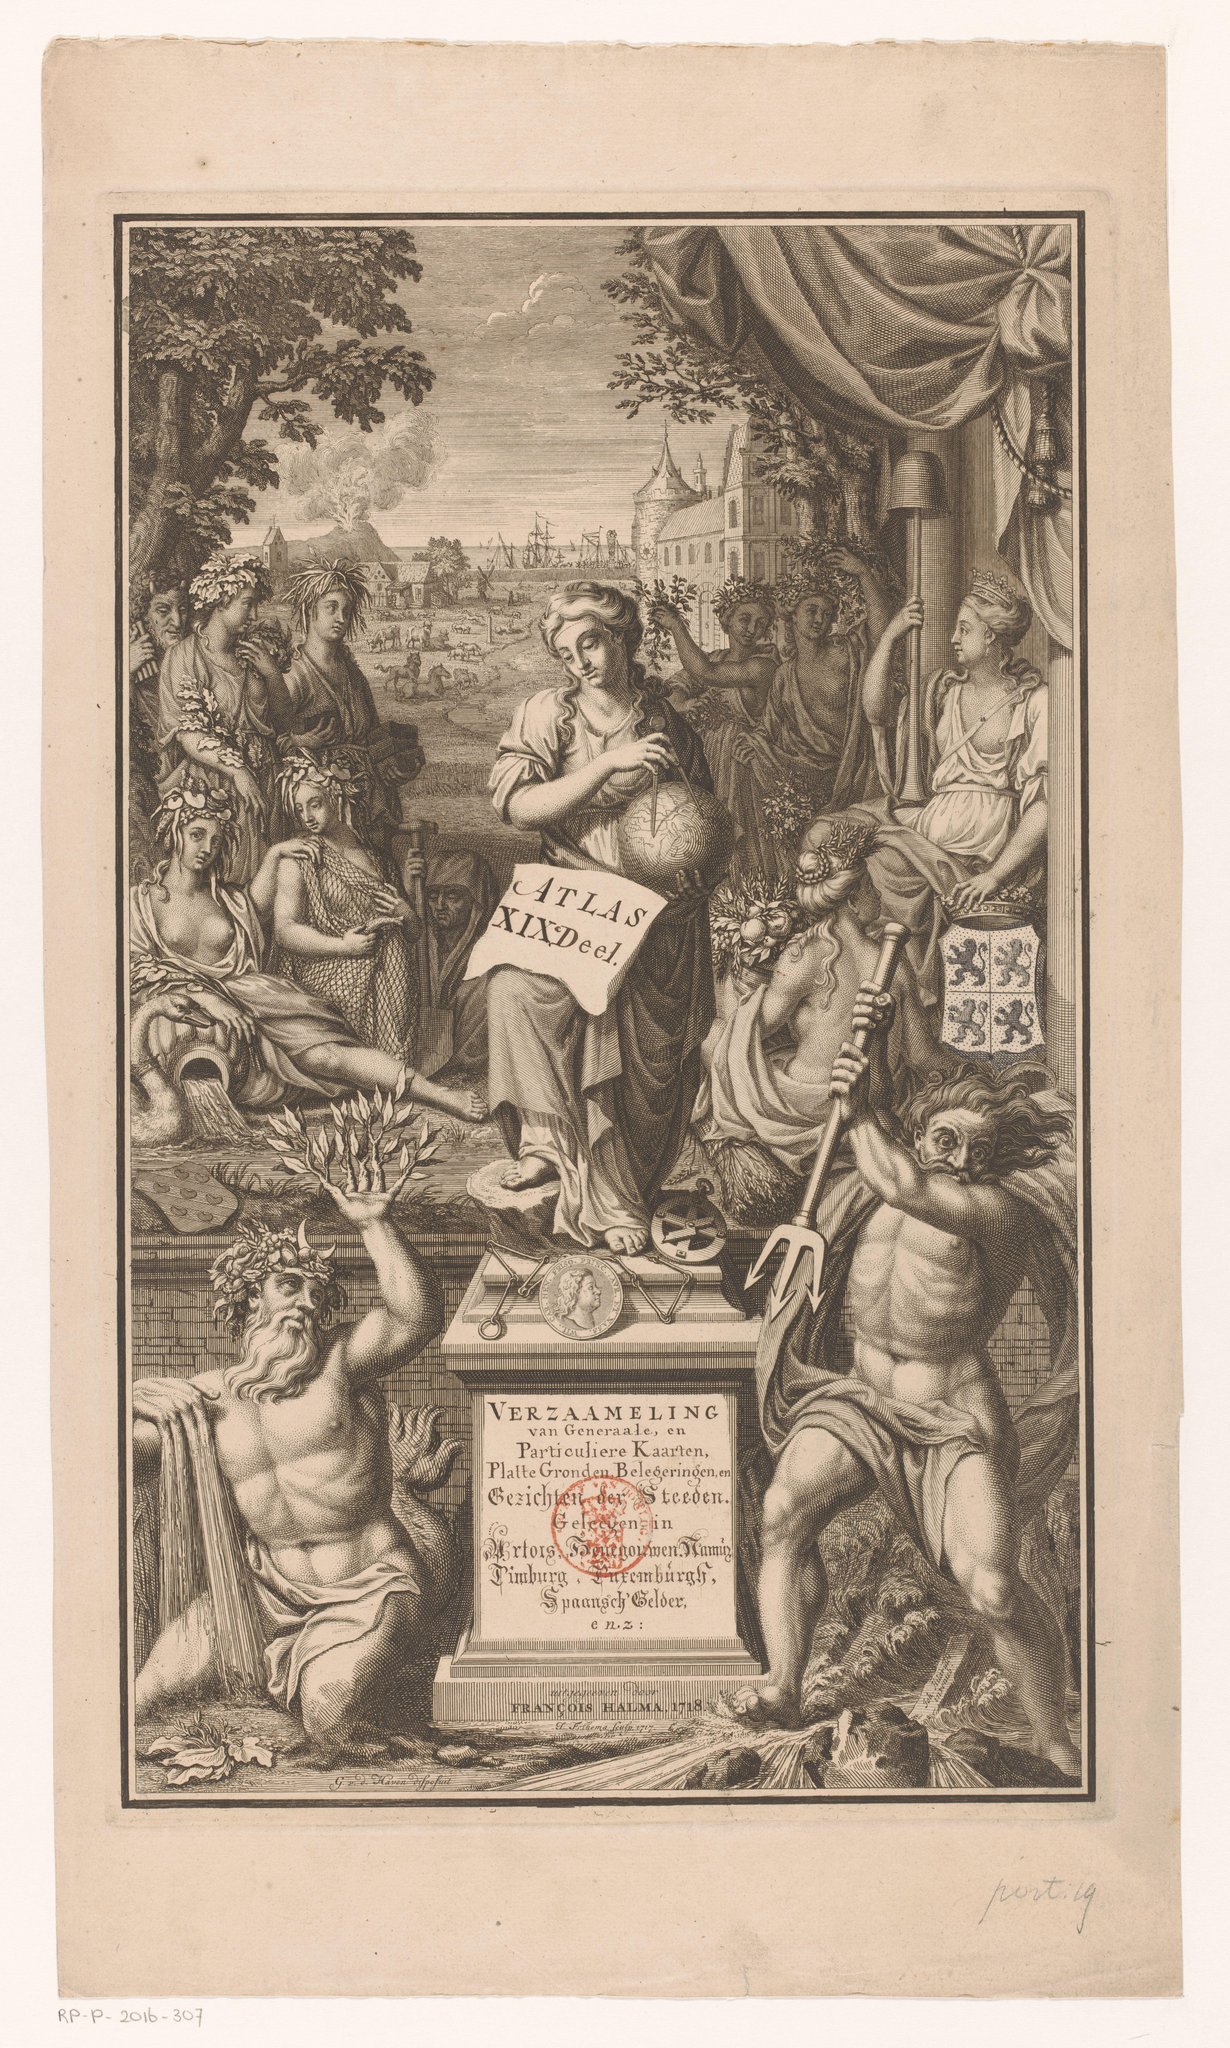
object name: titelprent, frontispice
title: Atlas XIXe Deel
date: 1717-1718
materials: ink, paper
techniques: engraving, etching, pen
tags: commercial fishery, (story of) ceres (demeter), peat-cutting, 'astronomia', 'cosmografia'; 'cosmografia' (ripa), personifications of countries, nations, states, districts, etc., river-gods, 'corografia', 'geografia', 'hidrografia' (ripa), agriculture, fruitfulness, productiveness, fertility, fecundity; 'fecondità' (ripa), (story of) flora, coat of arms (as symbol of the state, etc.) (+ province; provincial), neptune as lord of the sea, gelderland, henegouwen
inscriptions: collector's mark: Lugt 2228, collector's mark: Lugt 19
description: Deze prent is hier gebruikt als titelprent van een deel van een ongebonden atlas; een verzameling cartografische en topografische prenten en tekeningen. Oorspronkelijk was de prent echter bedoeld als titelpagina voor een gebonden atlas met kaarten van Friesland, waardoor een deel van de hier volgende beschrijving betrekking heeft op die context. Op het voetstuk in het midden staat de personificatie van de cartografie, met in haar hand een aardbol die ze met een passer meet. Op haar bovenbeen rust een blad met het handgeschreven deel van de atlas (oorspronkelijk een kaart van Friesland). Aan haar voeten een meetketting, een rond (land)meetkundig instrument en een portret van Willem IV van Oranje-Nassau. Daaronder de handgeschreven titel van dit deel van de atlas. Ze houdt een wakend oog op Wispelturigheid (Wispeltuer), linksonder. Oorspronkelijk staat hij voor de wispelturigheid waar het Friese land zich naar moest schikken: een bos kon opeens onder water staan, want zijn lichaam smelt door het zoute water van de zee. Linksboven zijn hoofd een wapenschild met het wapen van Friesland (met schuinbalken en pompeblêden). De dreiging van de zee is rechtsonder verbeeld door een onstuimige Neptunus (Zeevoogd). Links en rechts van Cartografie nog meer figuren die oorspronkelijk betrekking hadden op Friesland en haar vruchtbare natuur, visserij en landbouw. Links, met haar arm leunend op een kruik waar water uitstroomt, een stroomgodin (Stroomvoogdess) met rechts van haar de personificatie van de visserij (Visschevang). Boven hen van links naar rechts: een sater met fluit als personificatie van de natuur (Natuer), de personificatie van de bossen met eikenloven (Woudman) en personificatie van de turfwinning (vrouw Veenbrand). Rechtsonder haar vrouw Onland, die rouwt om de schade die de turfwinning aan het land veroorzaakt. Rechts van Cartografie zit Flora en/of Ceres (vrouw Veldgewas) met korenaren en cornucopia, ze staat voor de overvloed die voortvloeit uit het land. Boven haar, op de achtergrond, twee vrouwelijke personificaties die in verband staan met groene weides en/of grasvelden: Beemdeheil en Graazevol. Rechts, met in haar ene hand een bazuin met daarop een vrijheidshoed en in de andere hand een schild met een wapen met vier leeuwen (Henegouwen?), de personificatie van het gebied van dit deel van de atlas (oorspronkelijk de Friese Maagd met het provinciewapen met twee leeuwen). Op de achtergrond een landschap met kenmerkende Friese elementen, zoals het Sjaerdemaslot te Franeker en de vuurspuwende Rode Klif te Gaasterland (zou in de oudheid een vulkaan zijn geweest).